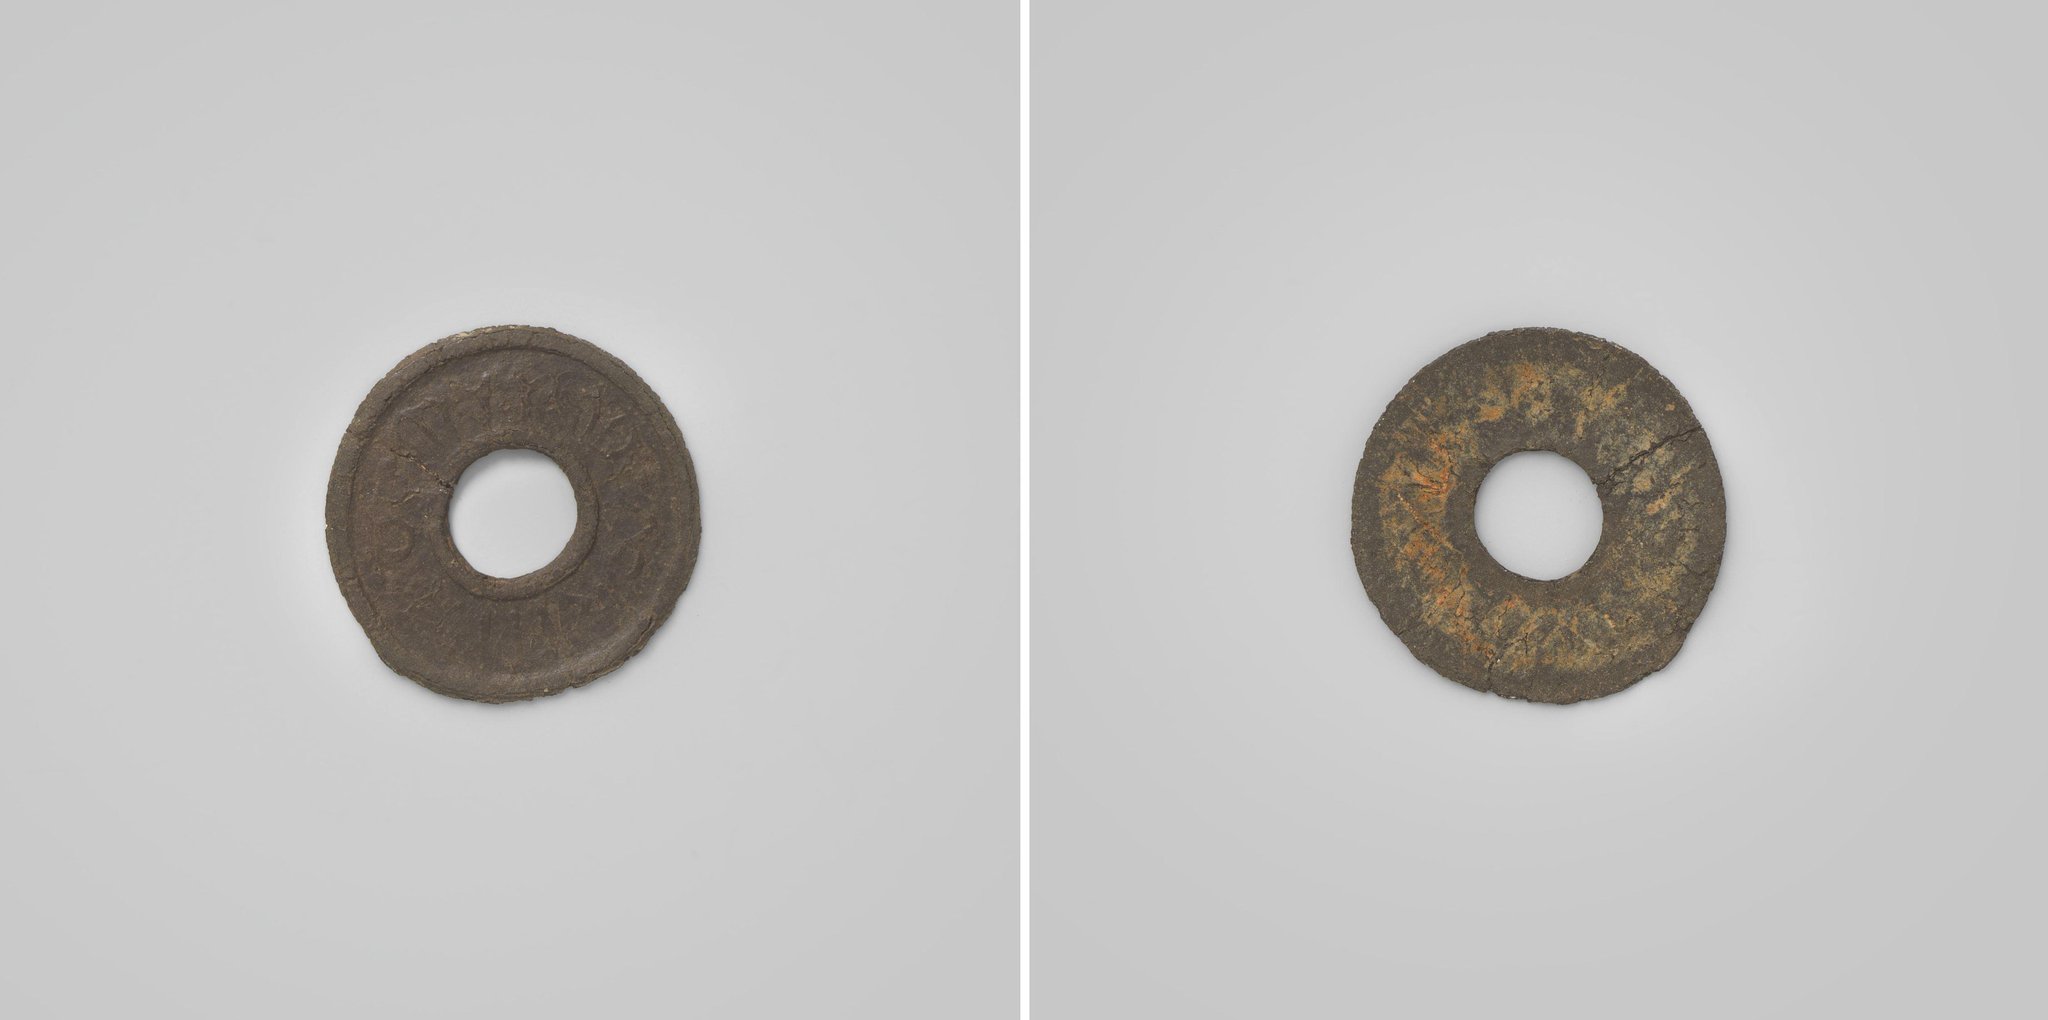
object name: coin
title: Munt Palembang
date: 1769-1821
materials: copper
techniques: striking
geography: palembang